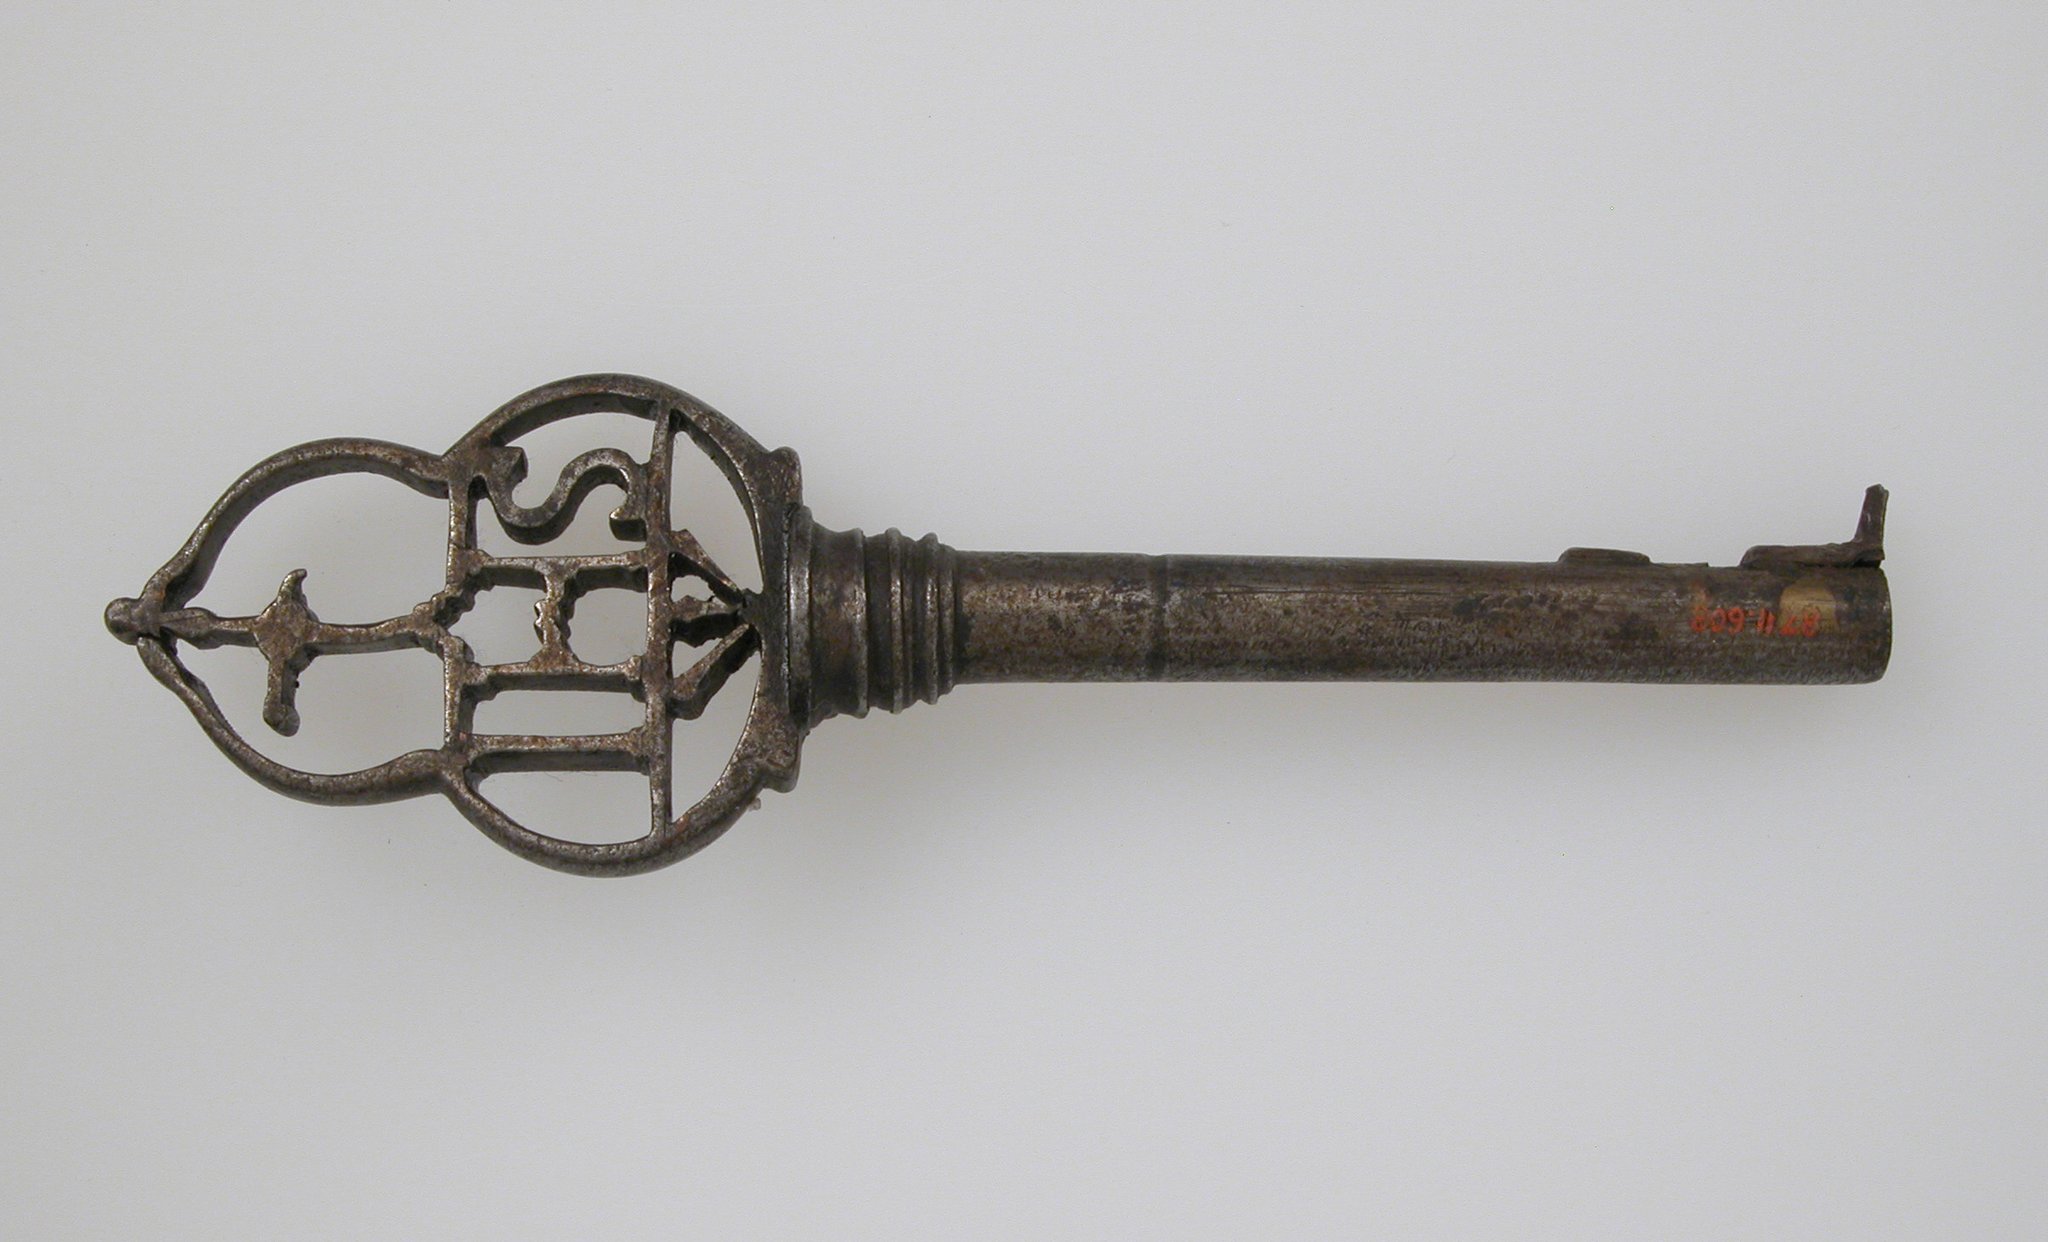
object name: key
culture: catalan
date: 1501-1600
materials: iron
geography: spain